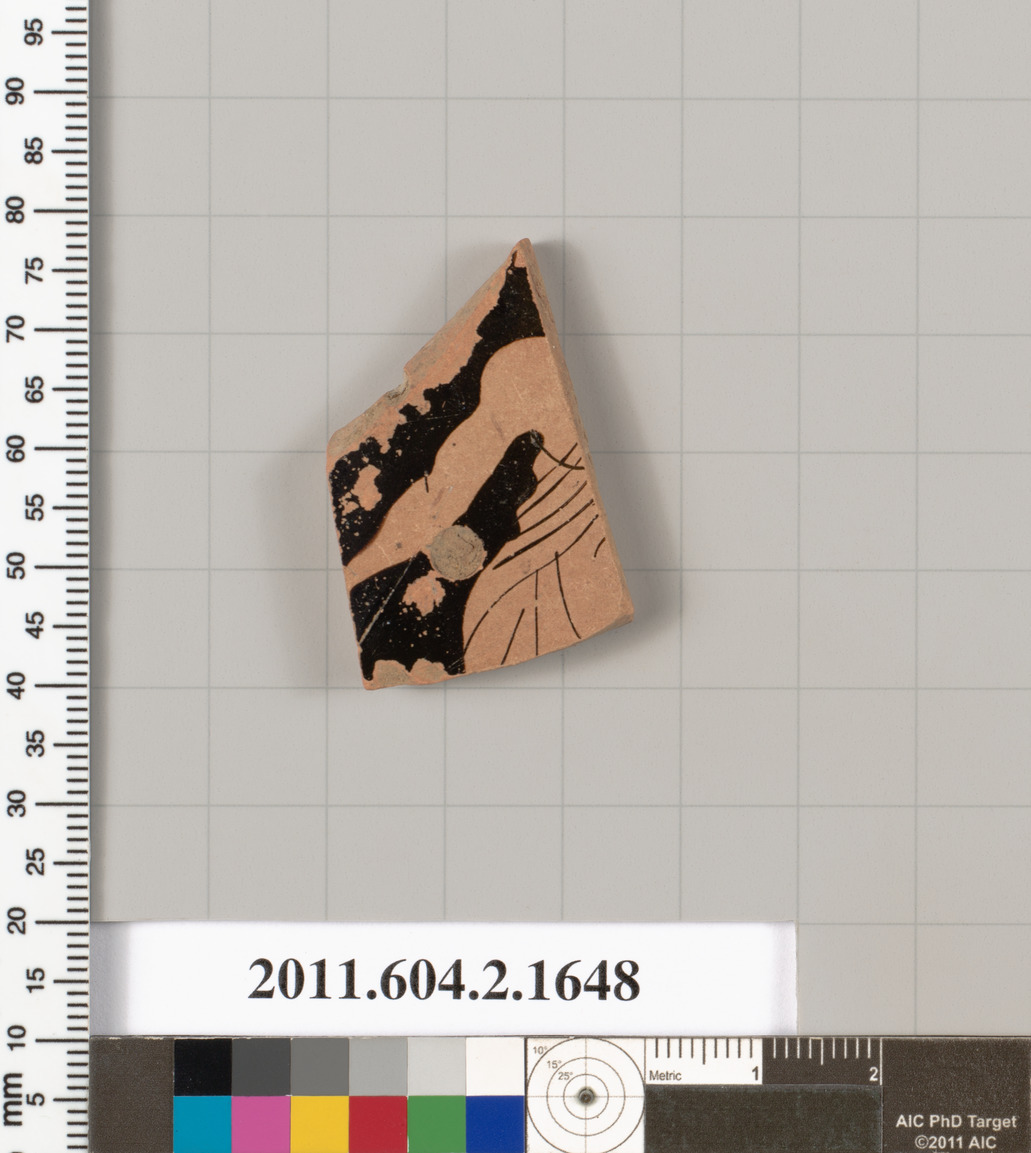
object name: skyphos fragment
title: Terracotta fragment of a skyphos (deep drinking cup)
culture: greek, attic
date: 450-426 BCE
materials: terracotta